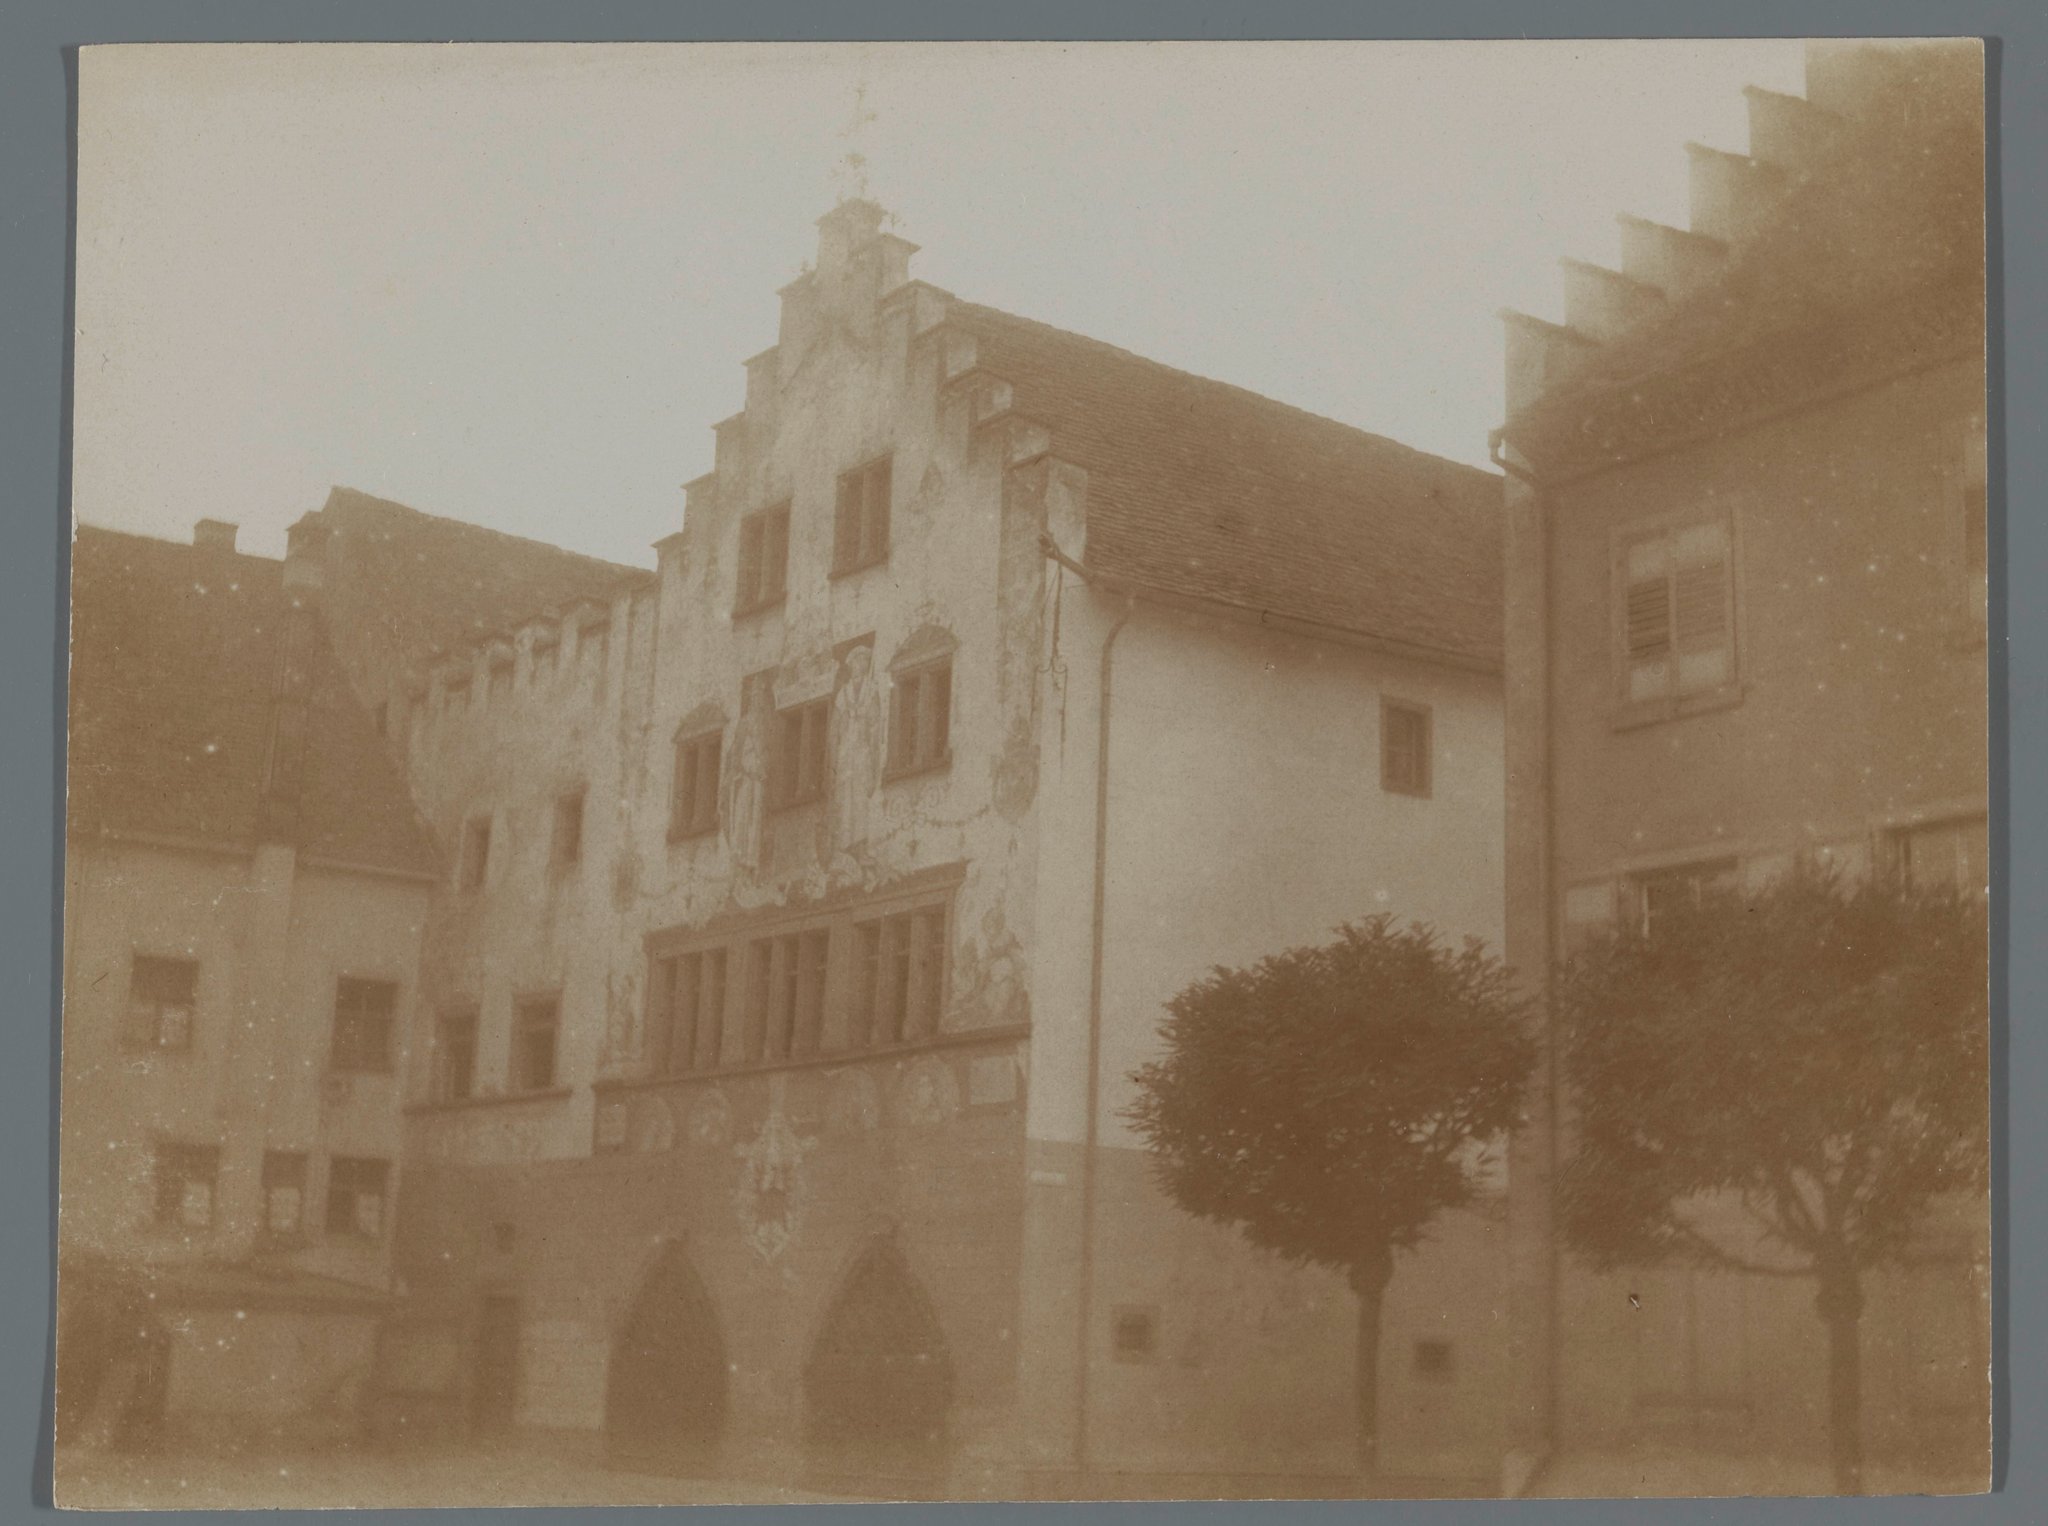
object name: photograph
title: Stadsgezicht met een kerk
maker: cornelia hendrika jonker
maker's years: 1874-1924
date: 1880-1940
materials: photographic support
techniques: collodion silver print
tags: city-view in general; 'veduta', church (exterior)